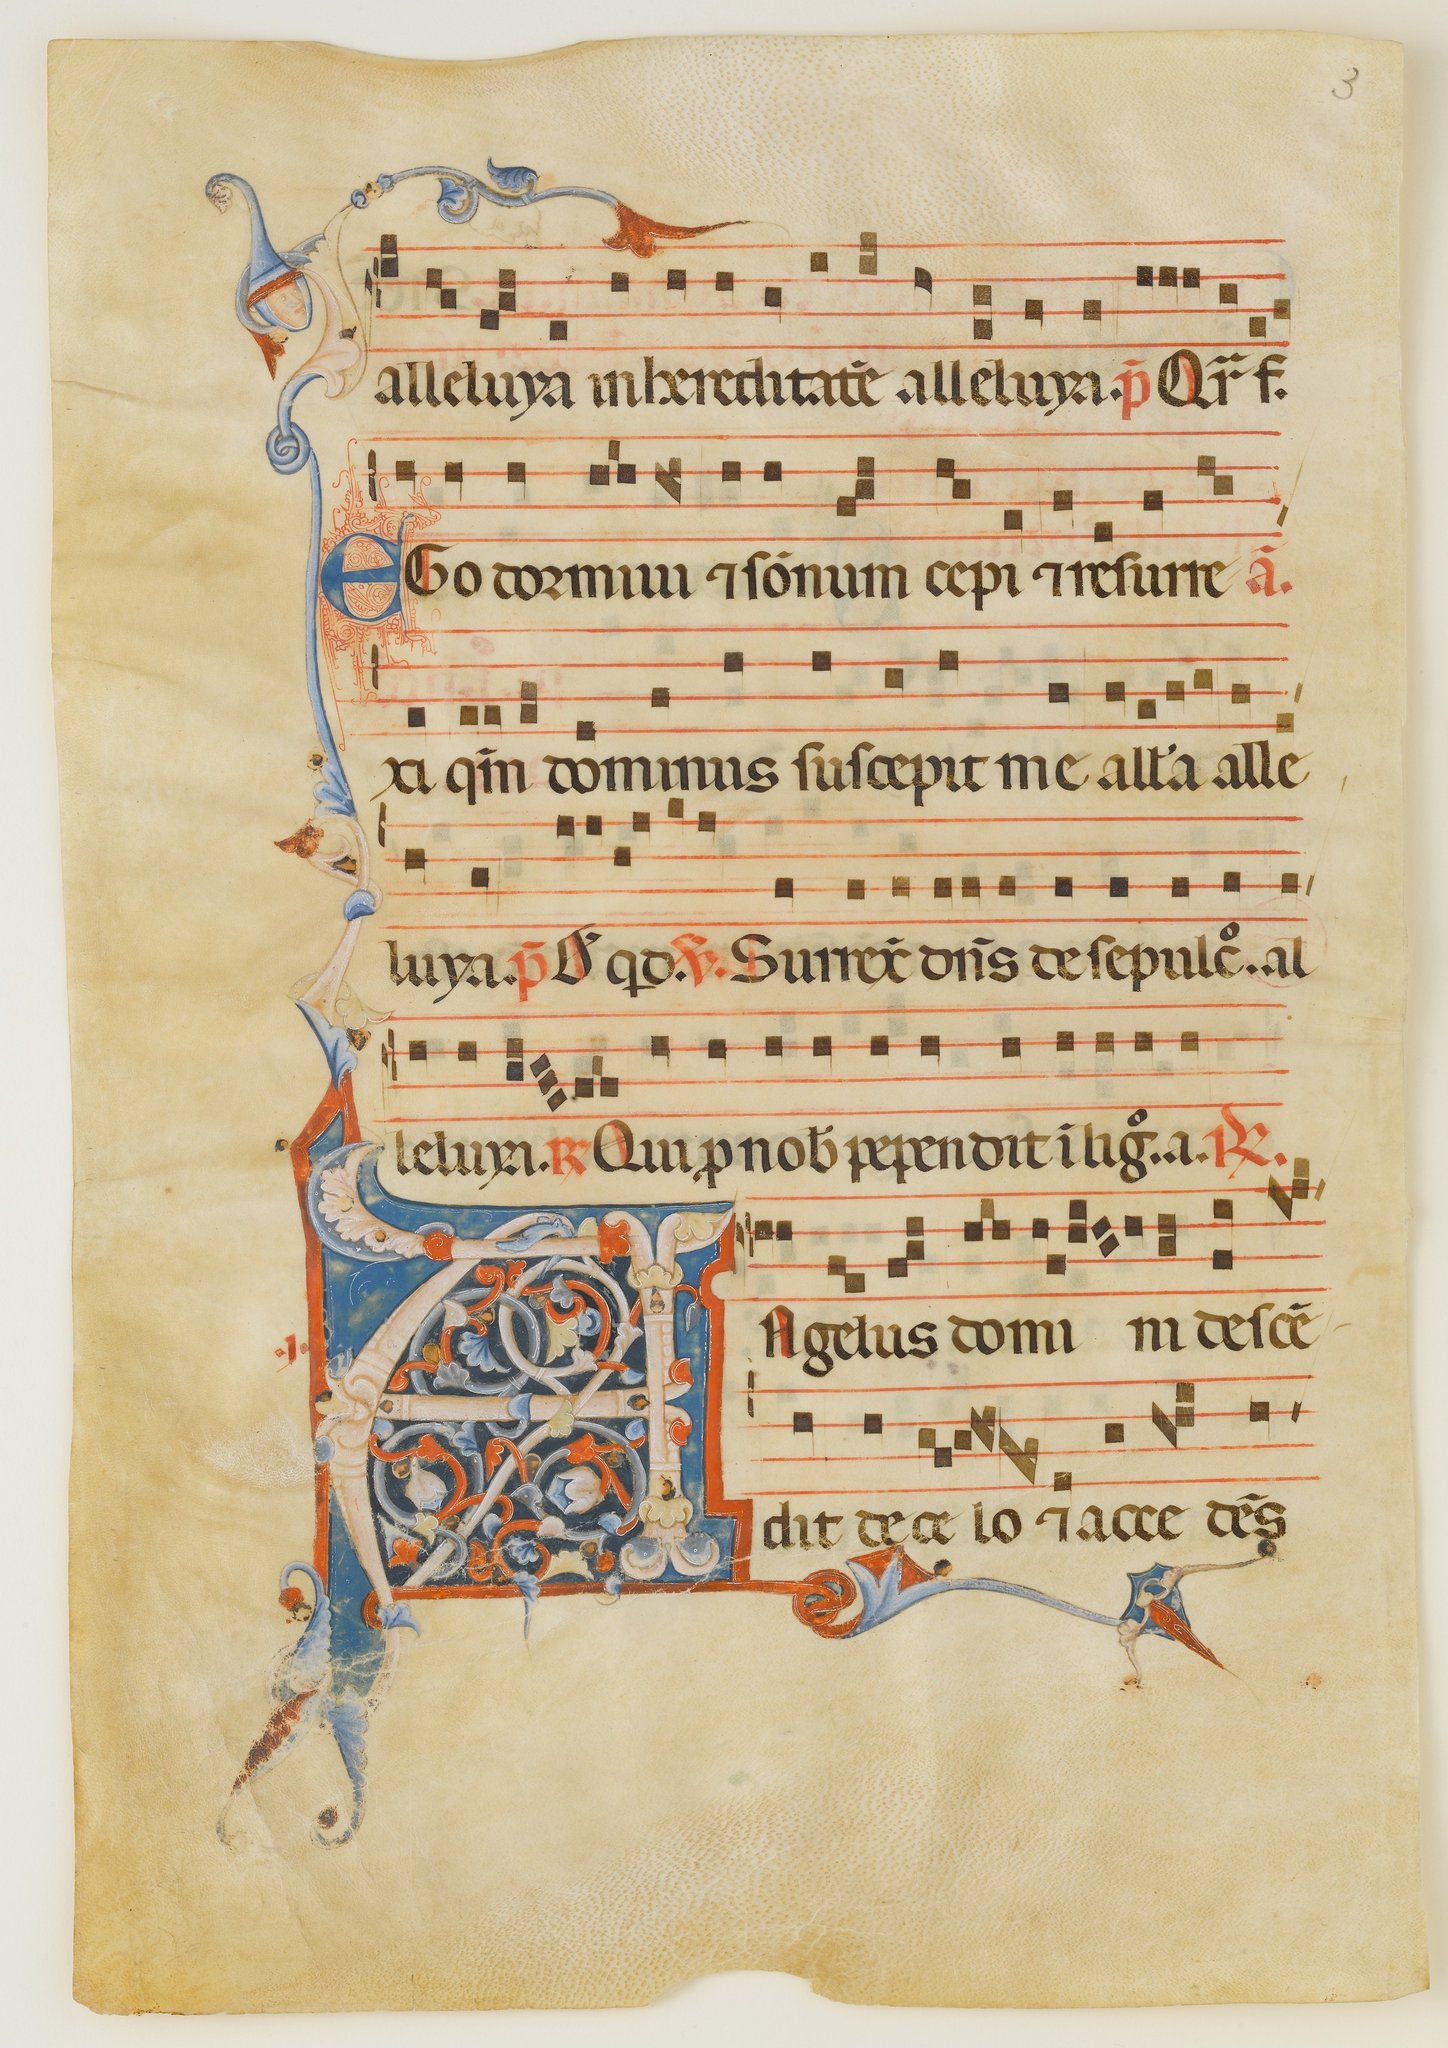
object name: antiphonary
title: Manuscript Leaf with Foliated Initial A, from an Antiphonary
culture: italian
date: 1301-1400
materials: ink, parchment, silver, paint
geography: italy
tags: music